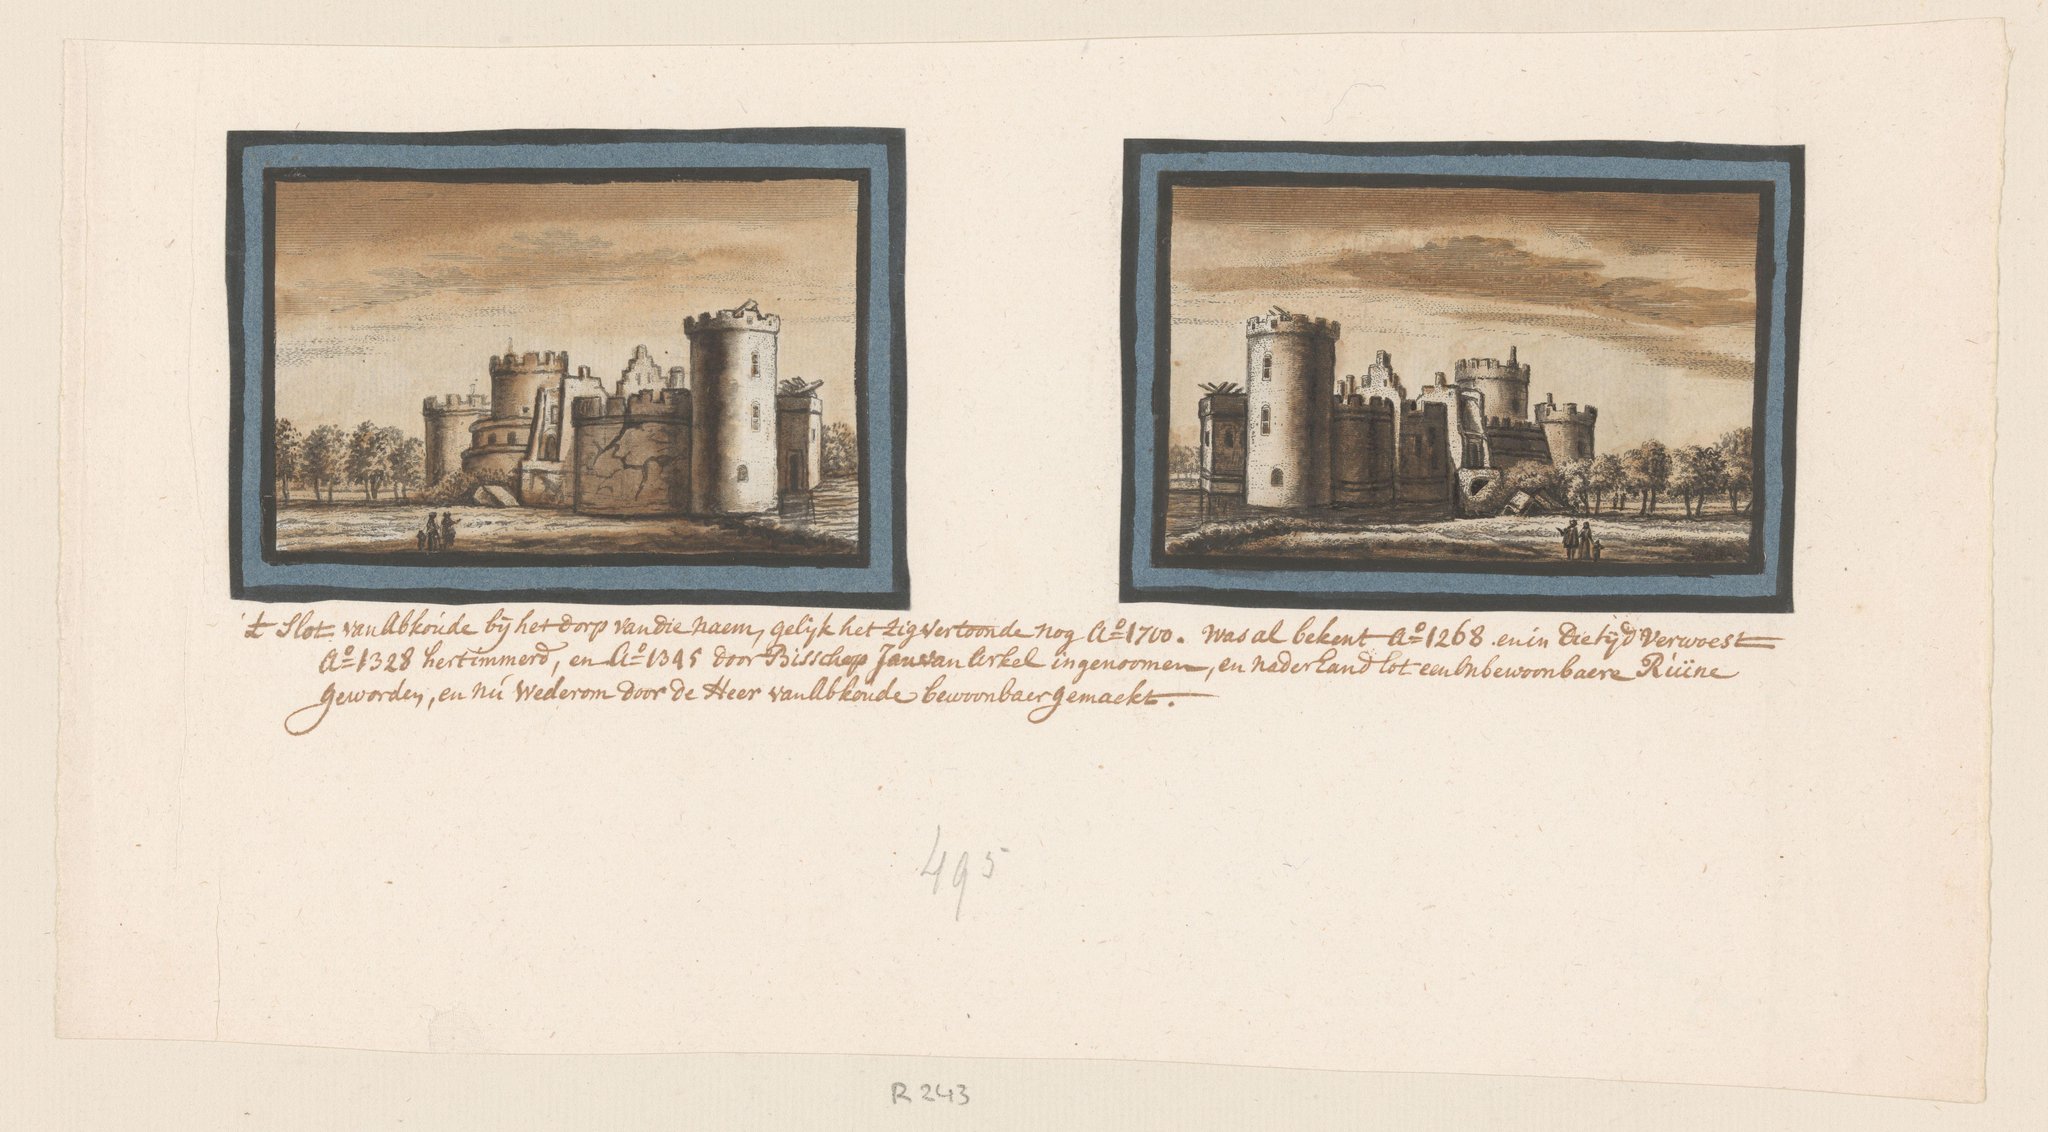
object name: book illustration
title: Gezichten op Slot Abcoude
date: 1725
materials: ink, paper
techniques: brush, etching, hand coloring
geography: amsterdam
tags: castle, landscape with tower or castle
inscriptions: annotation: ‘"'t Slot van Abkoude bij het dorp van die naem (...) wederom door de Heer van Abkoude bewoonbaer gemaekt."’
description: Op een oud opzetvel, met daarop een handgeschreven beschrijving van het afgebeelde object, rechts een ingekleurd exemplaar van de prent zoals die voorkomt als nr. 243 in: Rademaker, Abraham. Kabinet van Nederlandsche outheden en gezichten (...). Amsterdam: Willem Barents, 1725. Links op het opzetvel een spiegelbeeldige kopie van diezelfde prent, tevens ingekleurd.